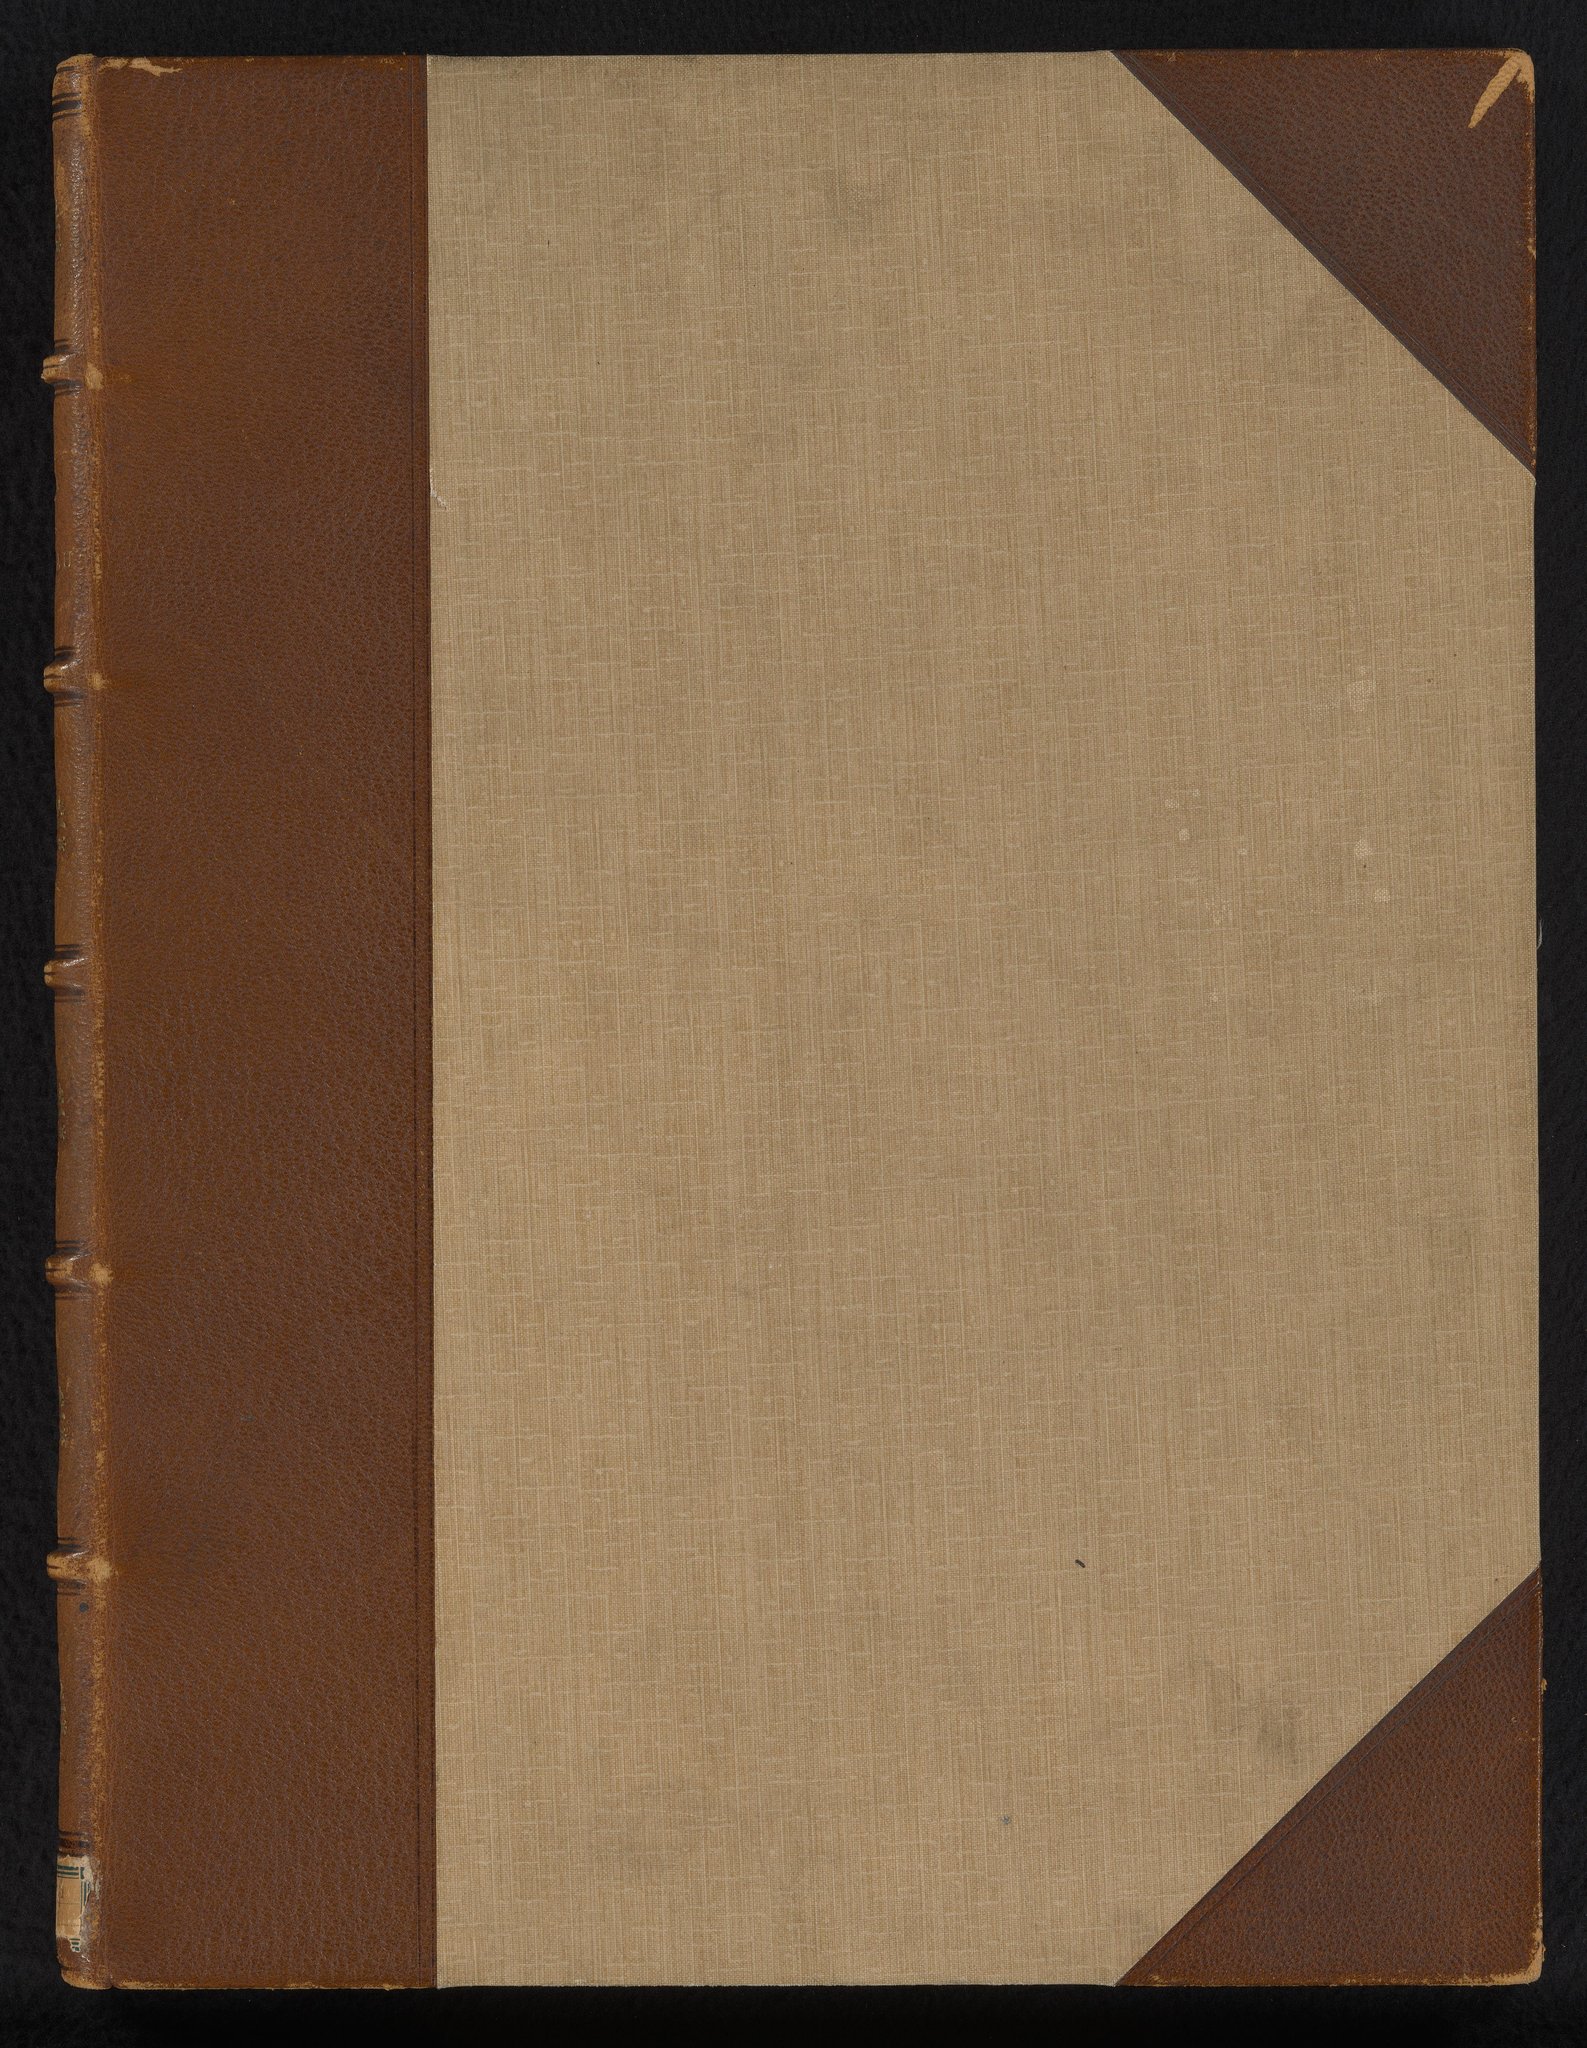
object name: prentrecueil, prentenalbum, prentalbum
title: Album met verschillende reeksen ornamentprenten naar ontwerpen van Nicolas Pineau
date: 1725-1750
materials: cardboard, leather, linen, paper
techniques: bookbinding, printing, etching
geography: paris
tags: ornaments ~ art, interior of the house, work of applied art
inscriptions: collector's mark: Lugt 2342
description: Prenten uit het midden van de achttiende eeuw, in een laat-negentiende-eeuwse of vroeg-twintigste-eeuwse band. De preten werden voor het grootste deel uitgegeven door Pierre Jean Mariette.